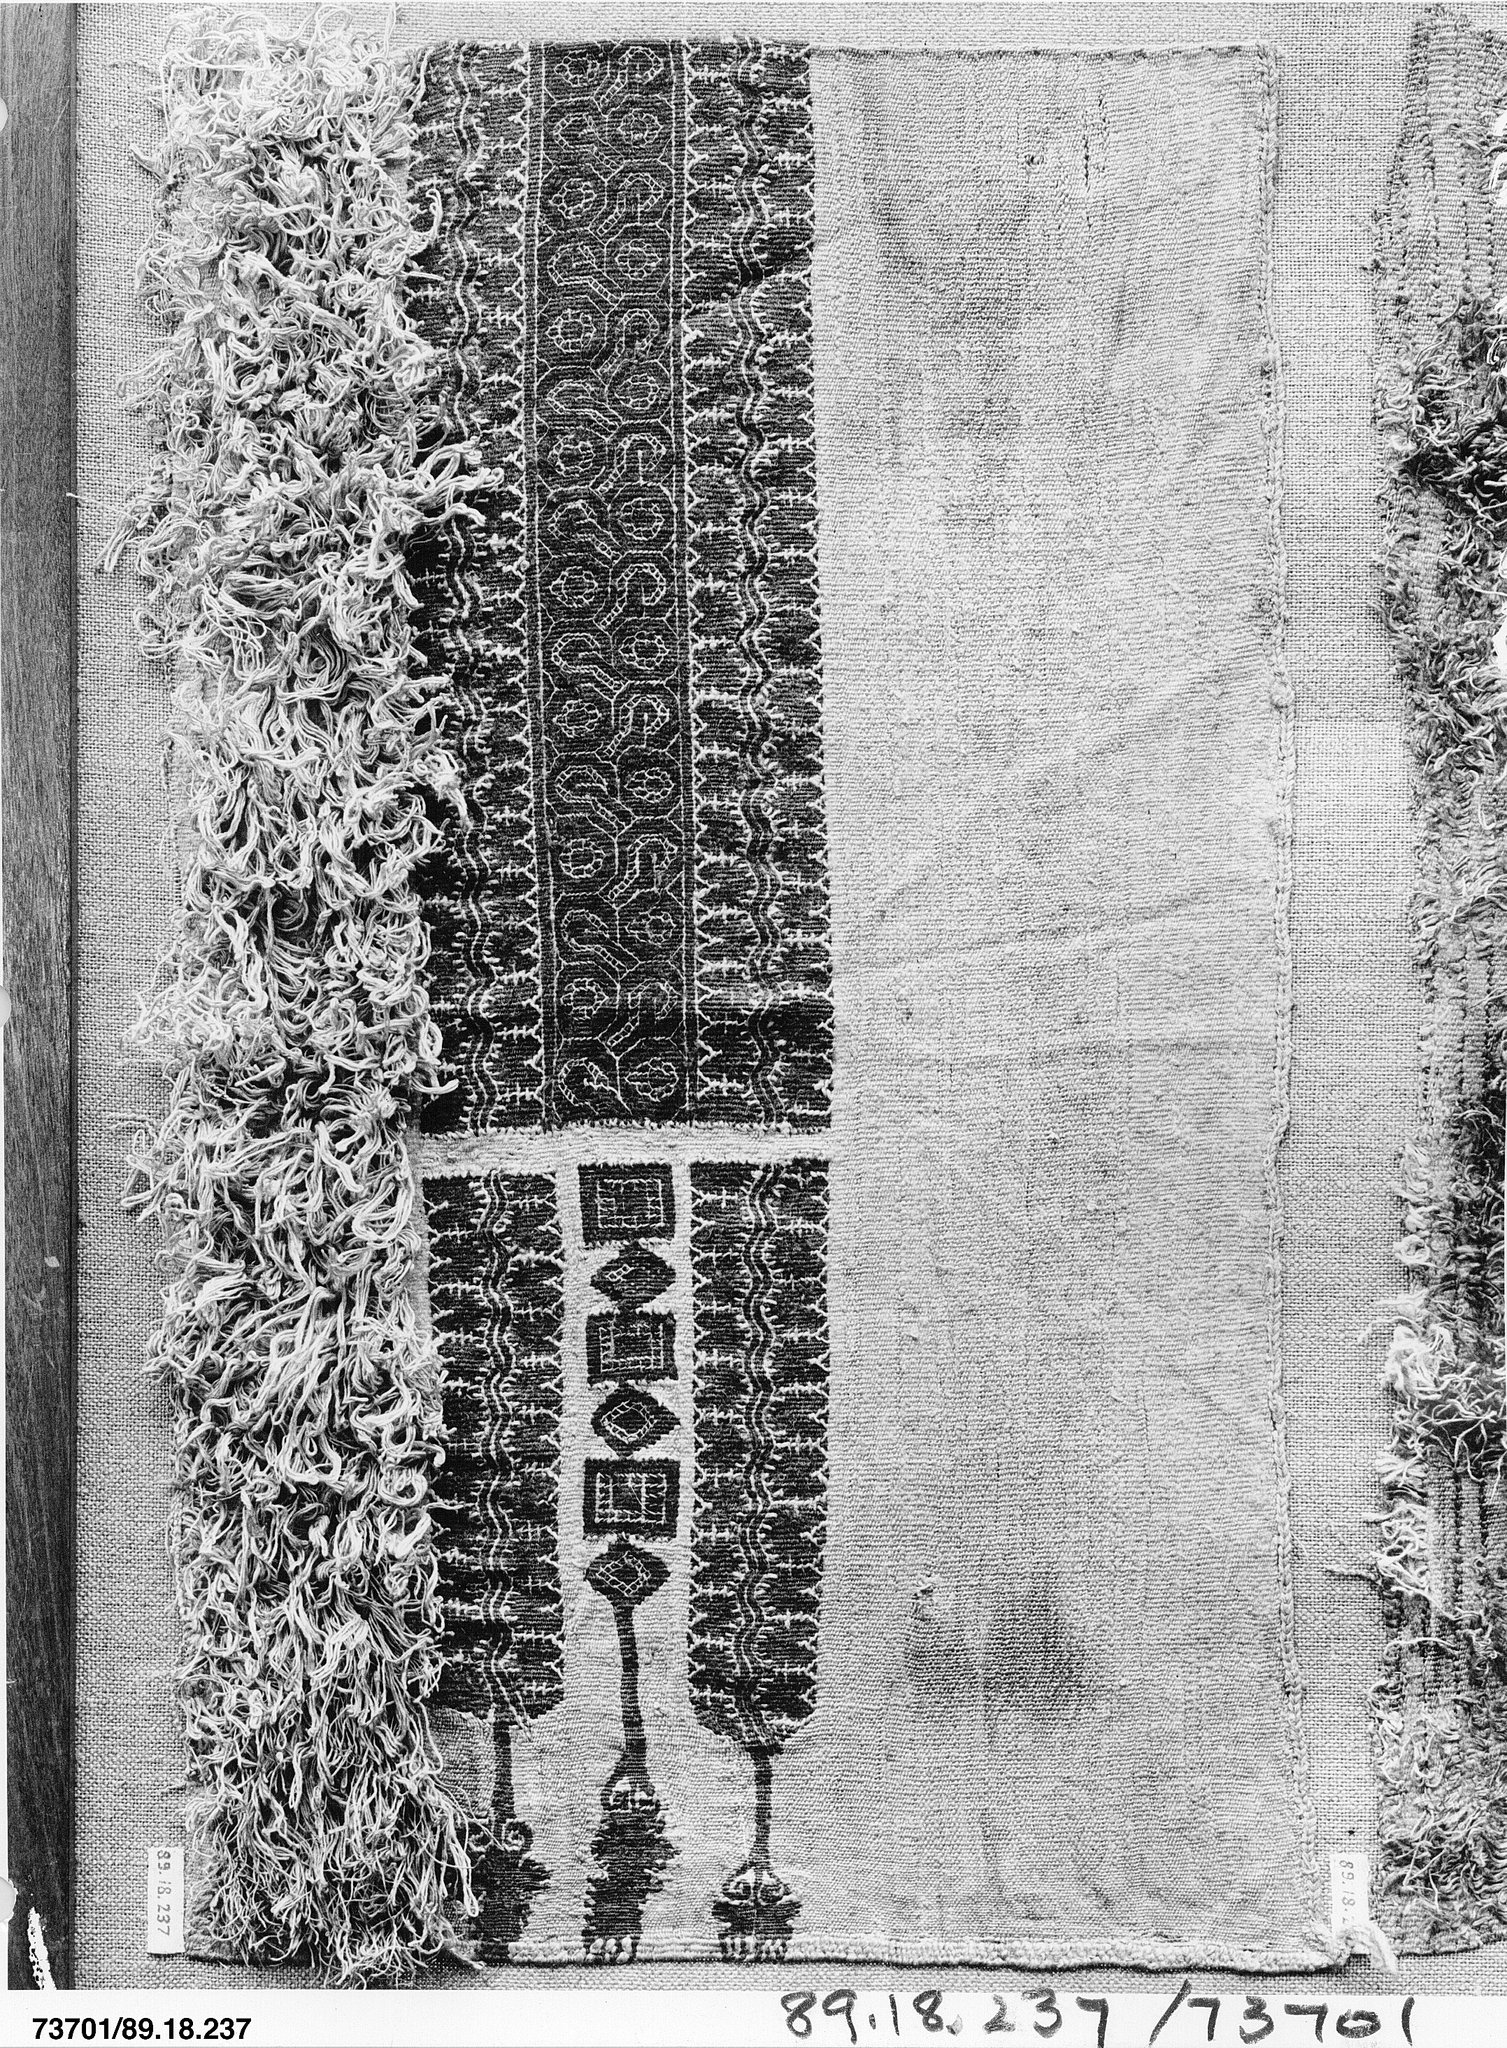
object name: textile fragment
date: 201-400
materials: linen, wool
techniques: weave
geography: egypt